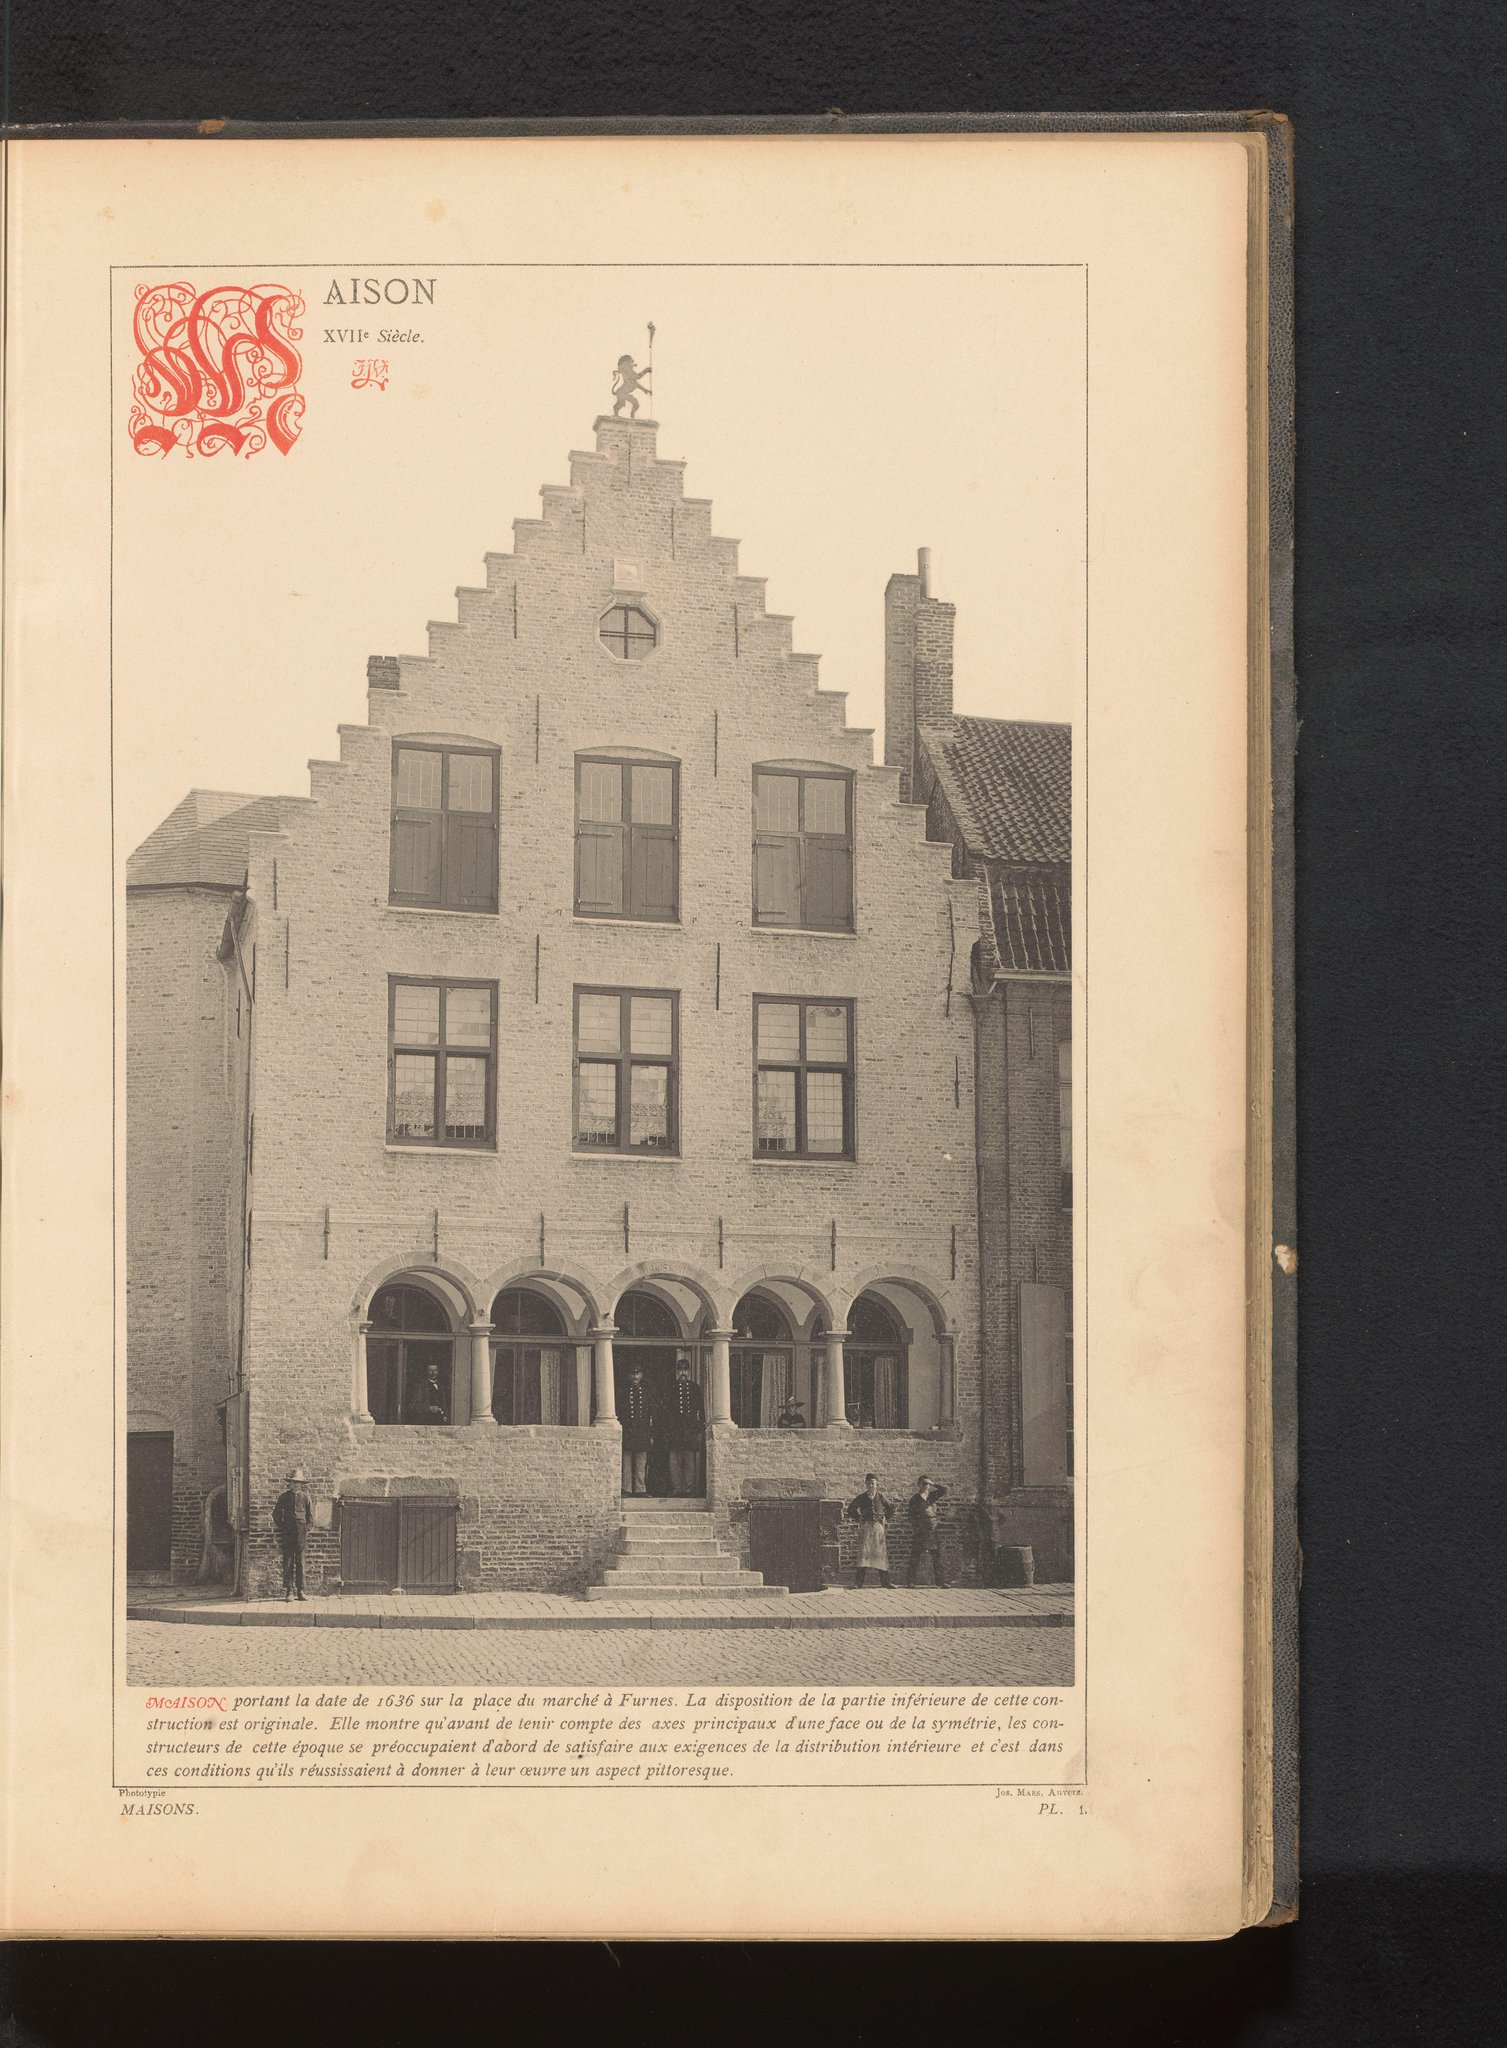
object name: page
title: Maison, XVIIe Siècle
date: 1881-1889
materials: paper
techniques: photograph, photolithography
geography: antwerp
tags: decorated gable, civic architecture; edifices; dwellings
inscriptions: monogram: ‘JJvY’, inscription: ‘MAISON portant la (...)’, inscription: ‘MAISONS. PL. 1.’